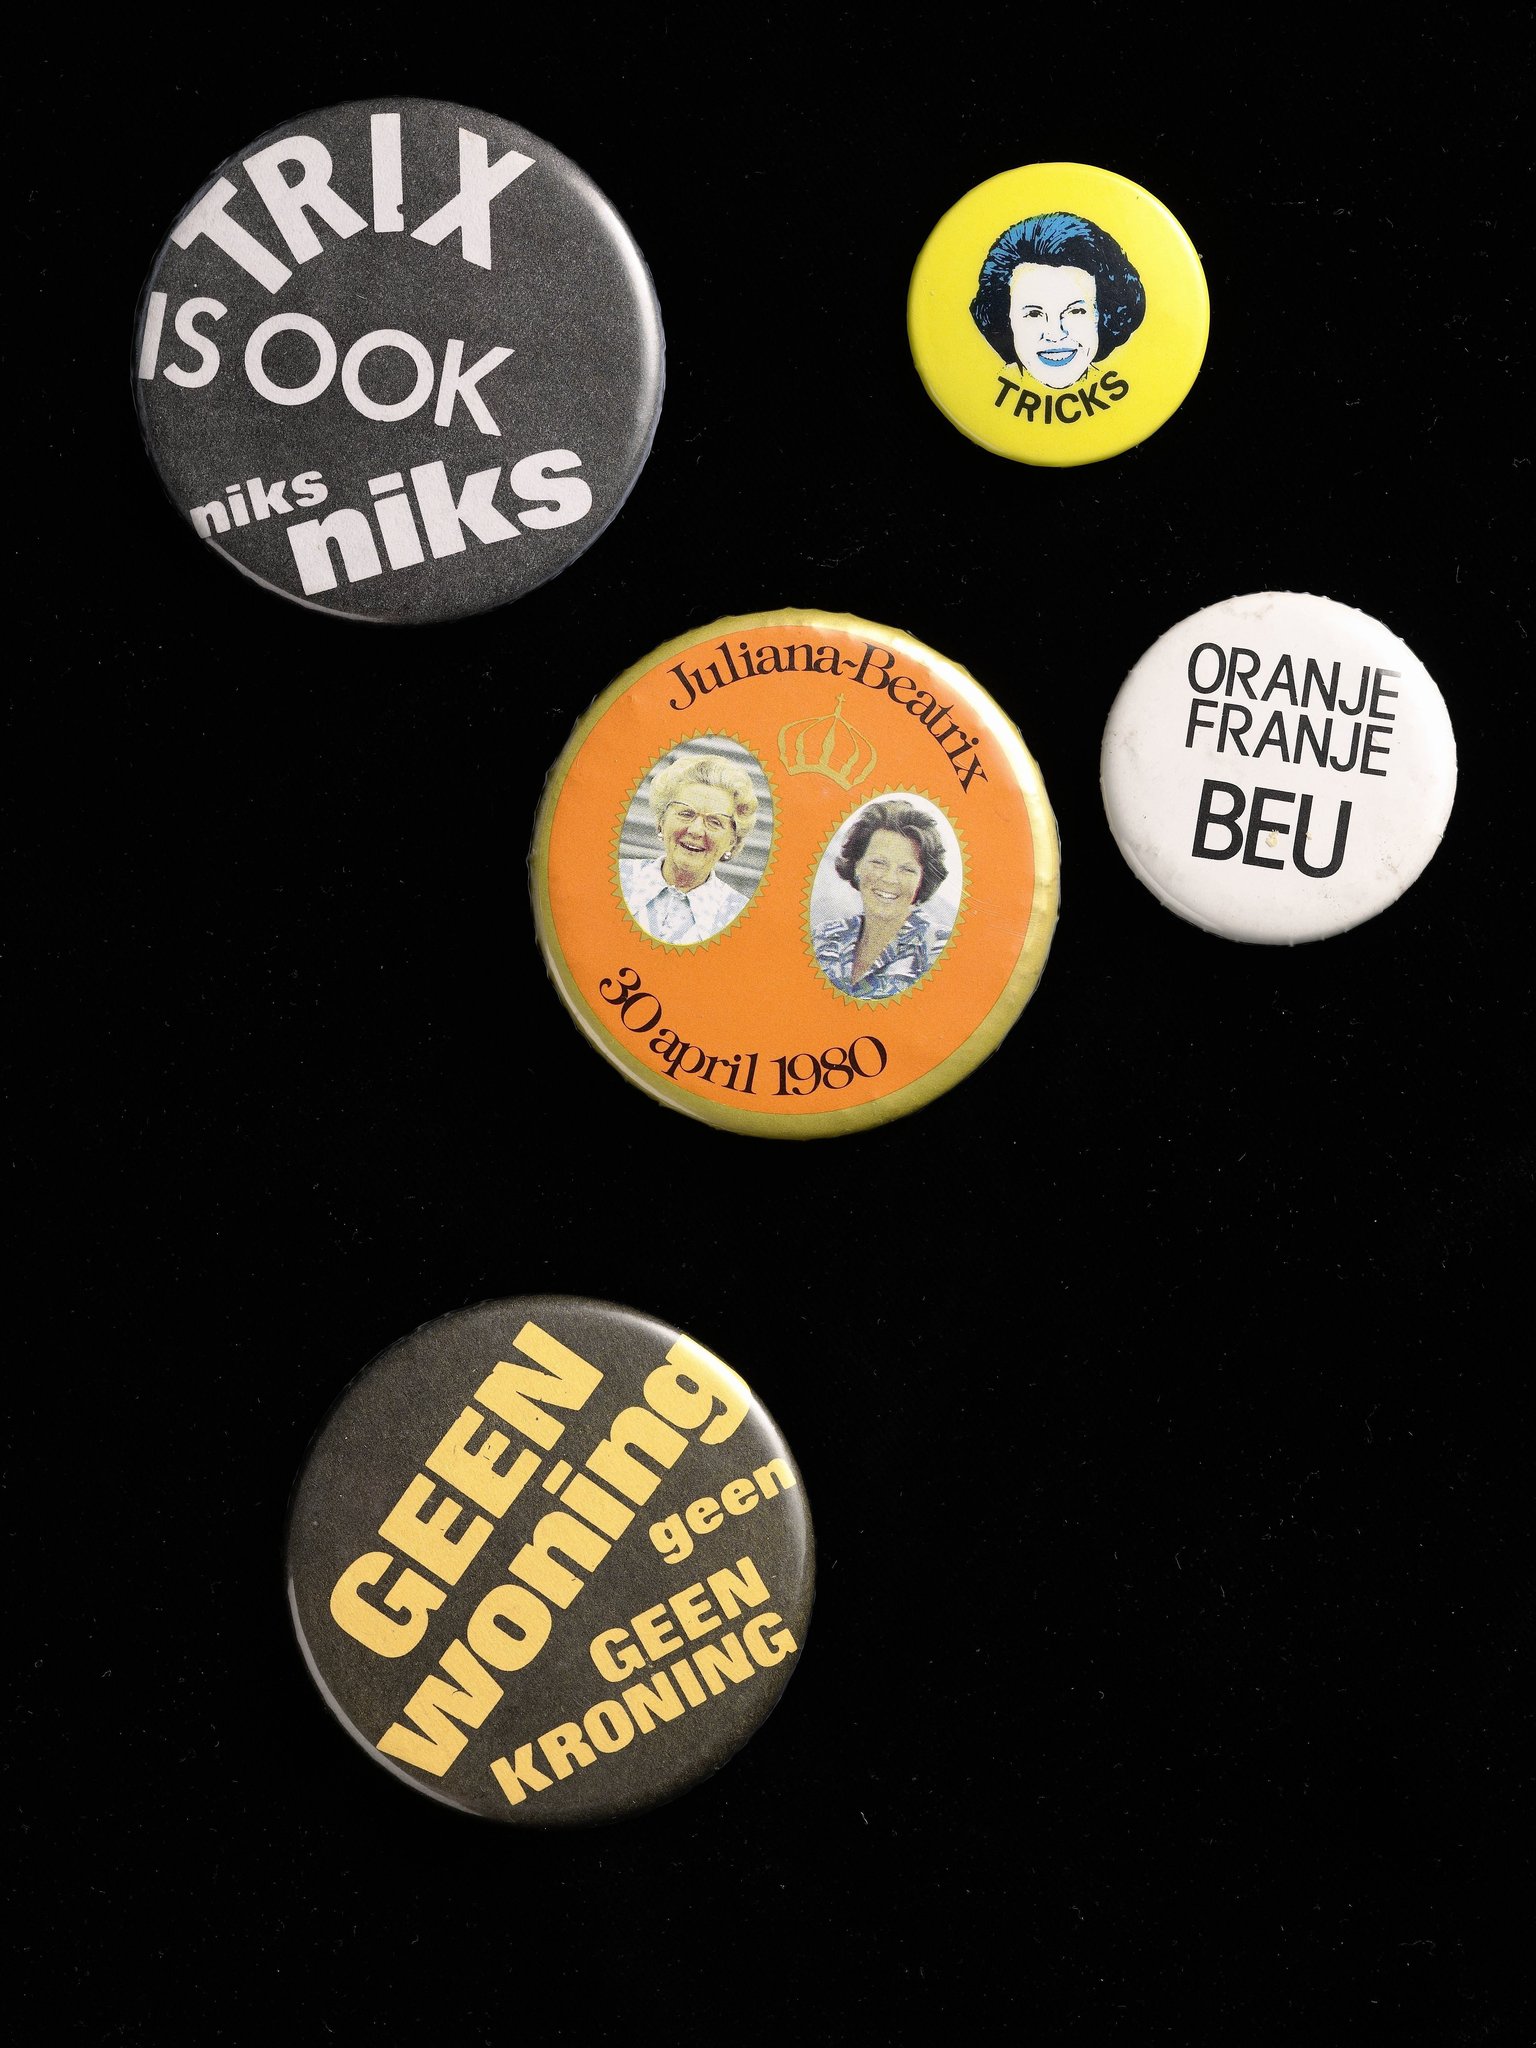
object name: button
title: Inhuldiging van koningin Beatrix, 30 april 1980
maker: Anonymous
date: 1980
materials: copper, metal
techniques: printing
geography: amsterdam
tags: beatrix (koningin der nederlanden), the hague, juliana of the netherlands, netherlands, inauguration of beatrix as queen of the netherlands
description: Oranje button met doorzichtige rand waarop de ovale portretten van Juliana en Beatrix. Hiertussen een gouden kroon. Tekst in zwart opgedrukt: Juliana - Beatrix; 30 april 1980. Achterzijde button is blauw en voorzien van een speld.